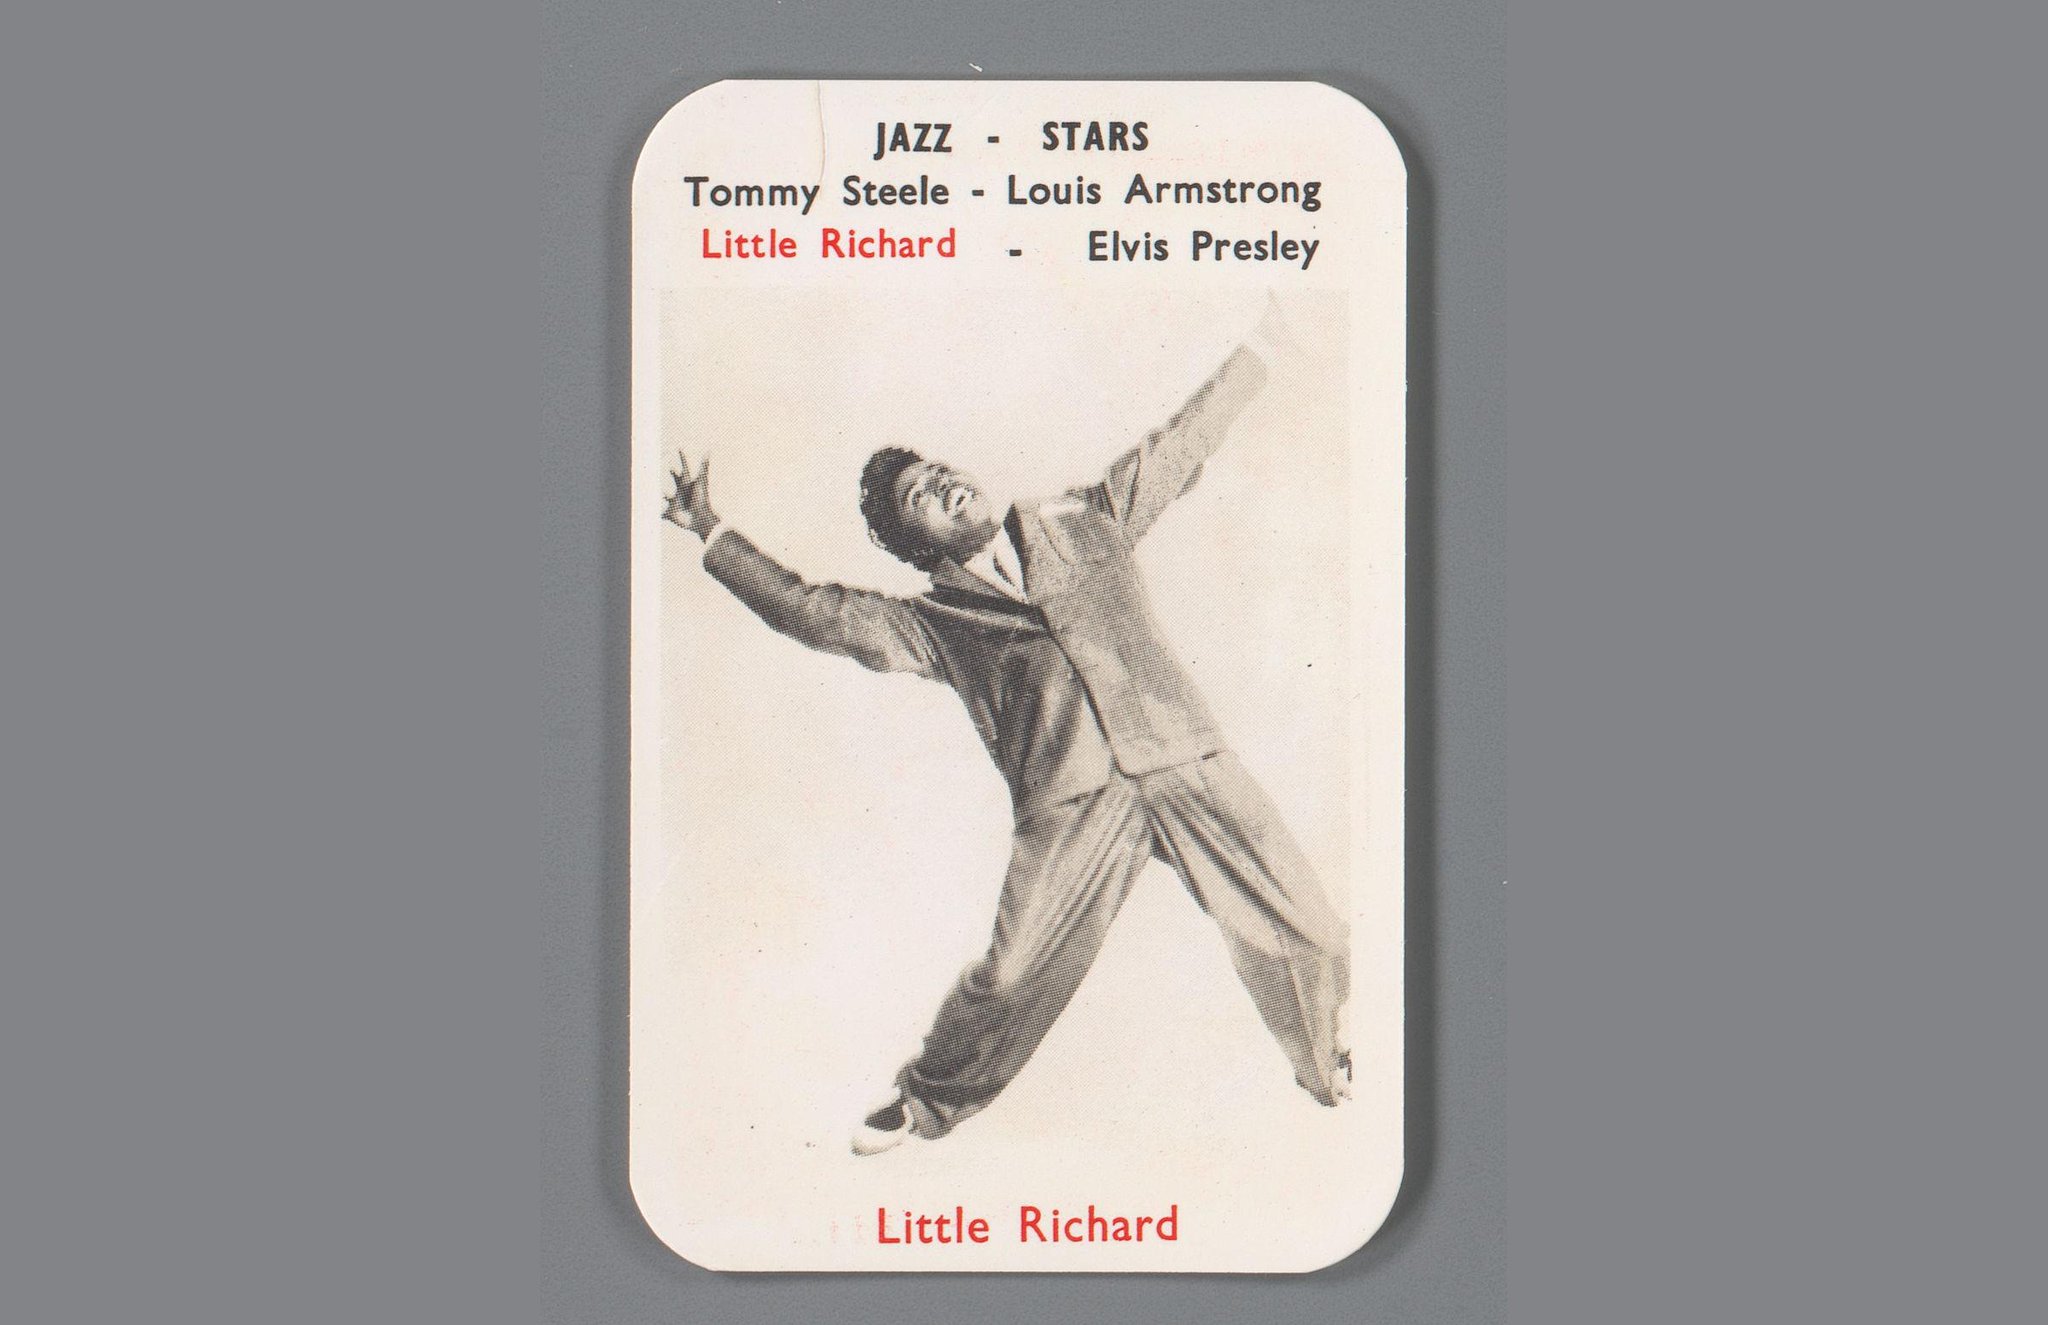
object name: playing card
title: Portret van Little Richard; onderdeel van het kwartet Jazz Stars uit een kwartetspel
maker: Anonymous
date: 1960-1970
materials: paper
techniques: autotype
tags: musician, portrait of a musician